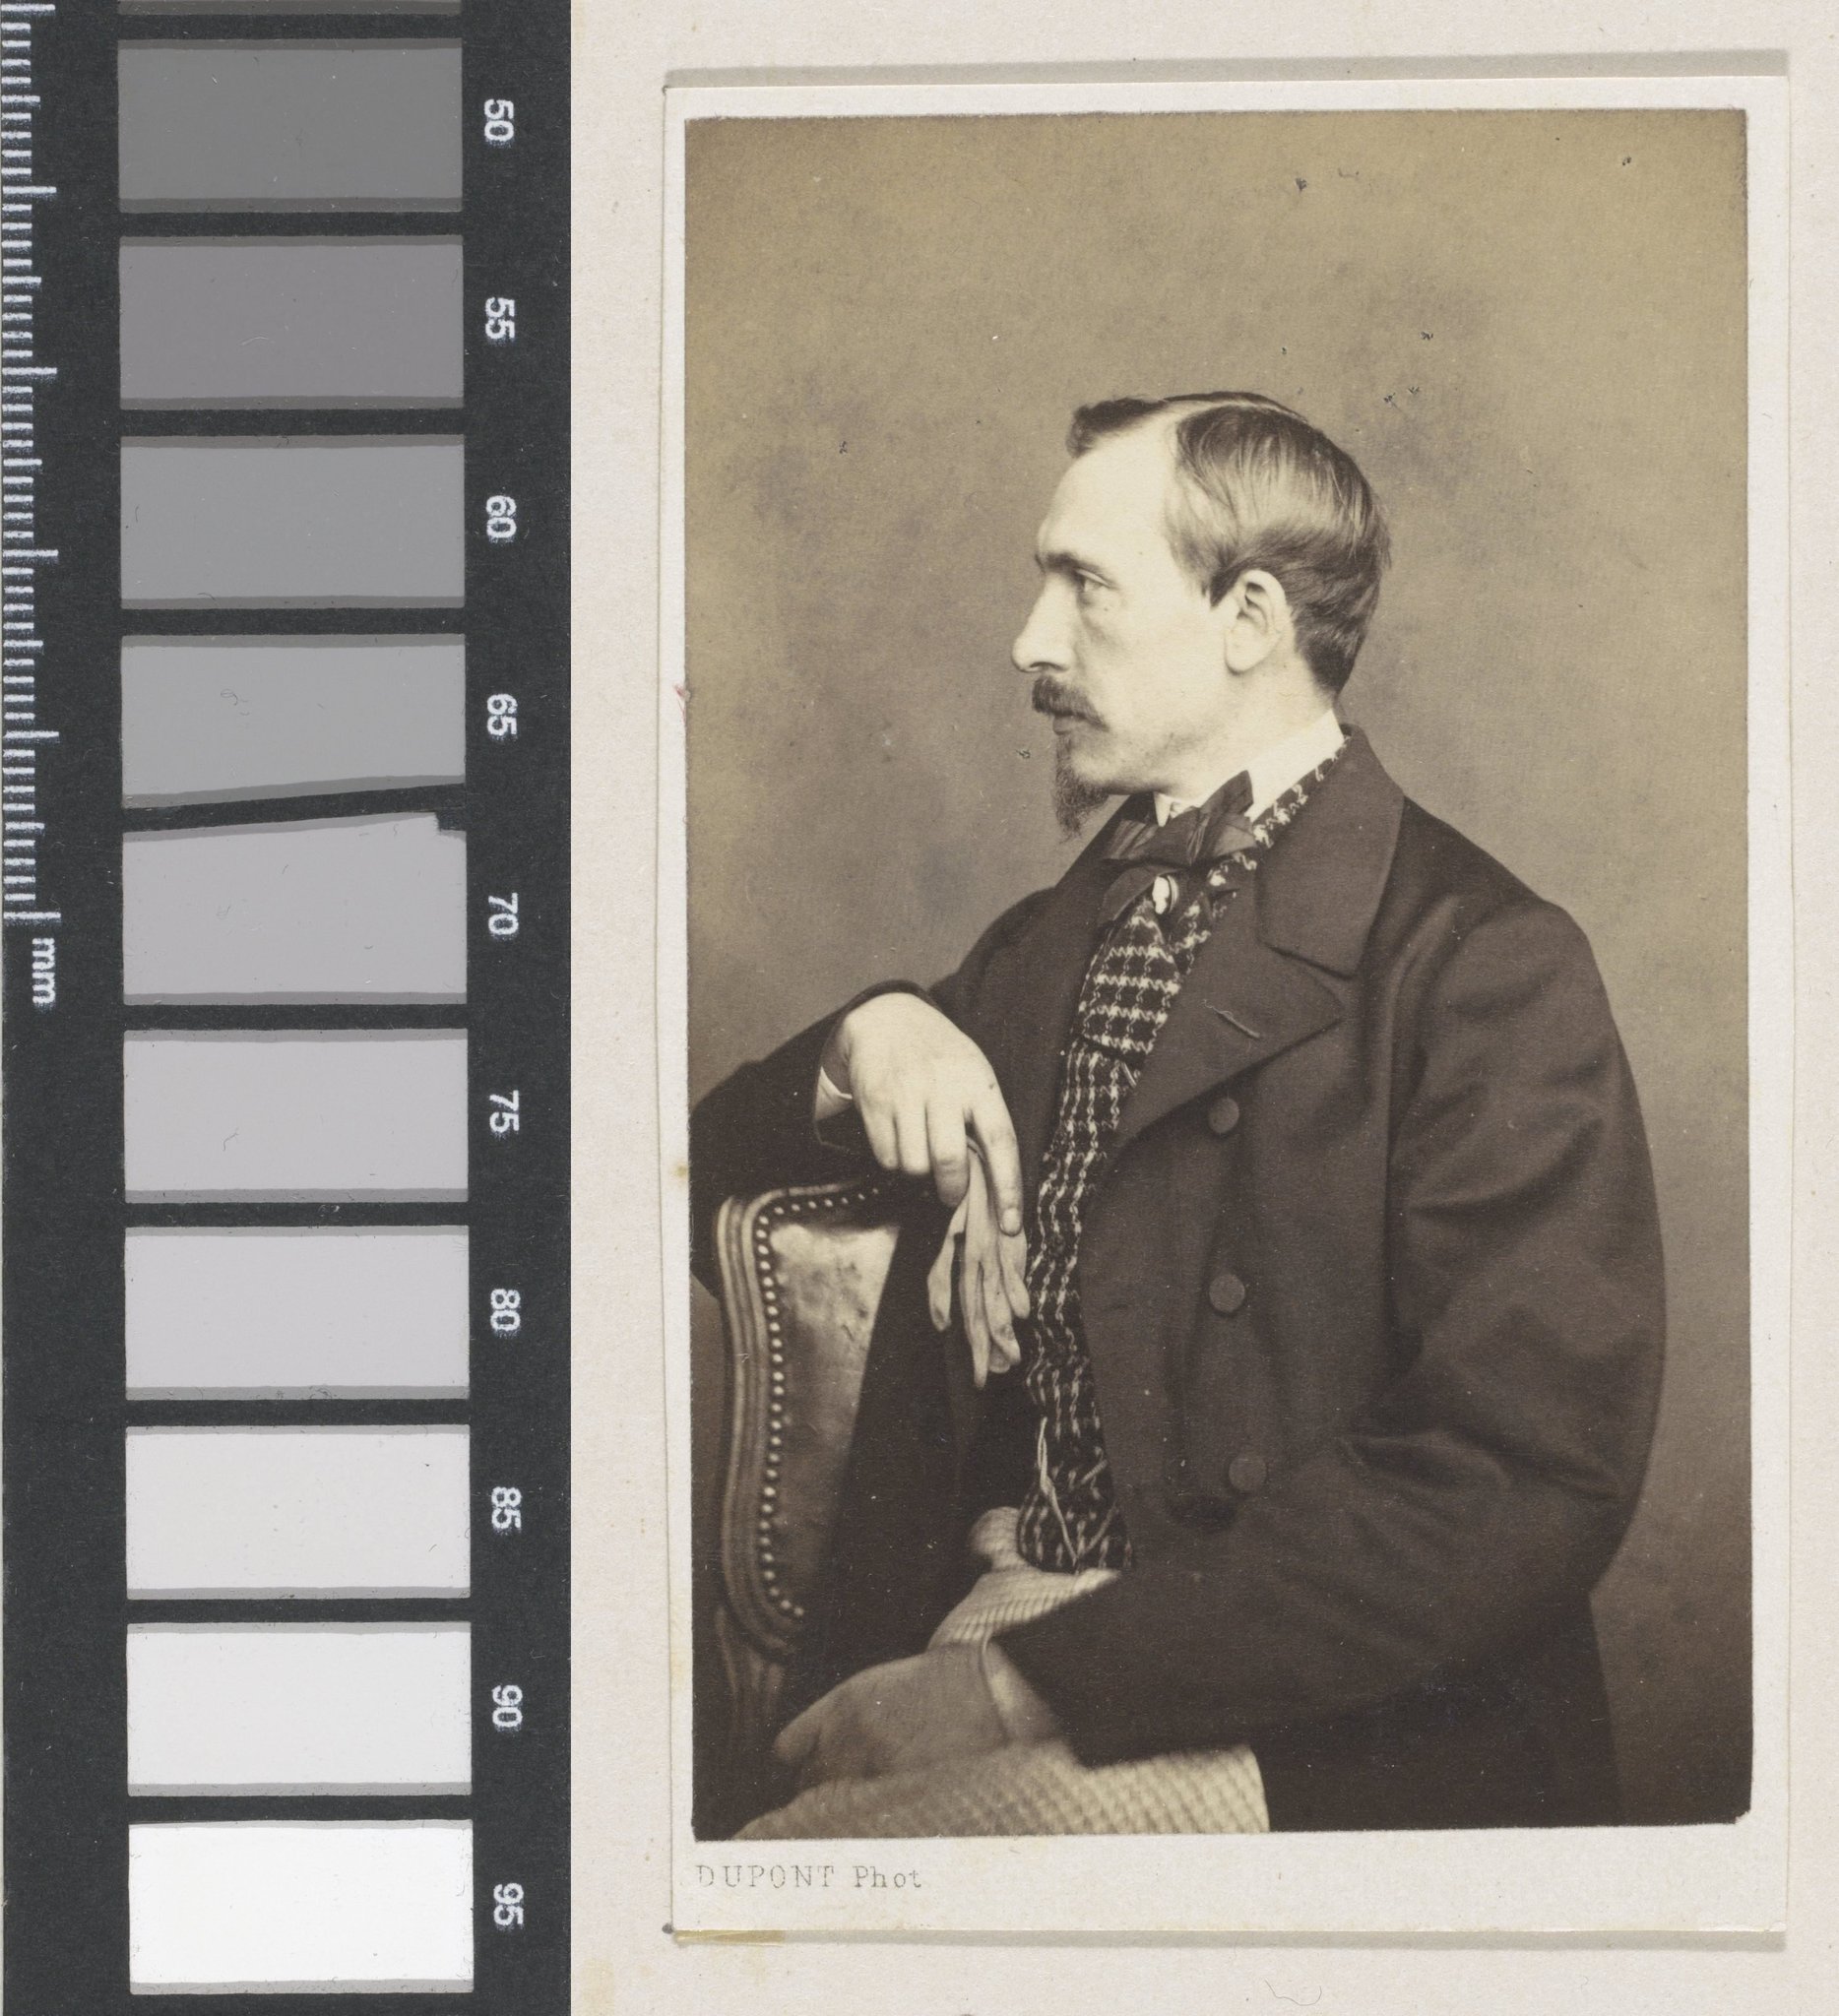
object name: photograph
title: Portret van de schilder Ferdinand Wilhelm Pauwels, halffiguur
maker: joseph dupont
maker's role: fotograaf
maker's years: 1818-1901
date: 1861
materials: cardboard, paper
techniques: albumen print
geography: antwerp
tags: print maker, ferdinand pauwels, historical persons, portrait, self-portrait of painter, portrait, self-portrait of artist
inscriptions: inscription: ‘ETABLISSEMENT PHOTOGRAPHIQUE/ de/ J. DUPONT/ Place de Meir 32/ ANVERS/ Maison fondée en 1853’